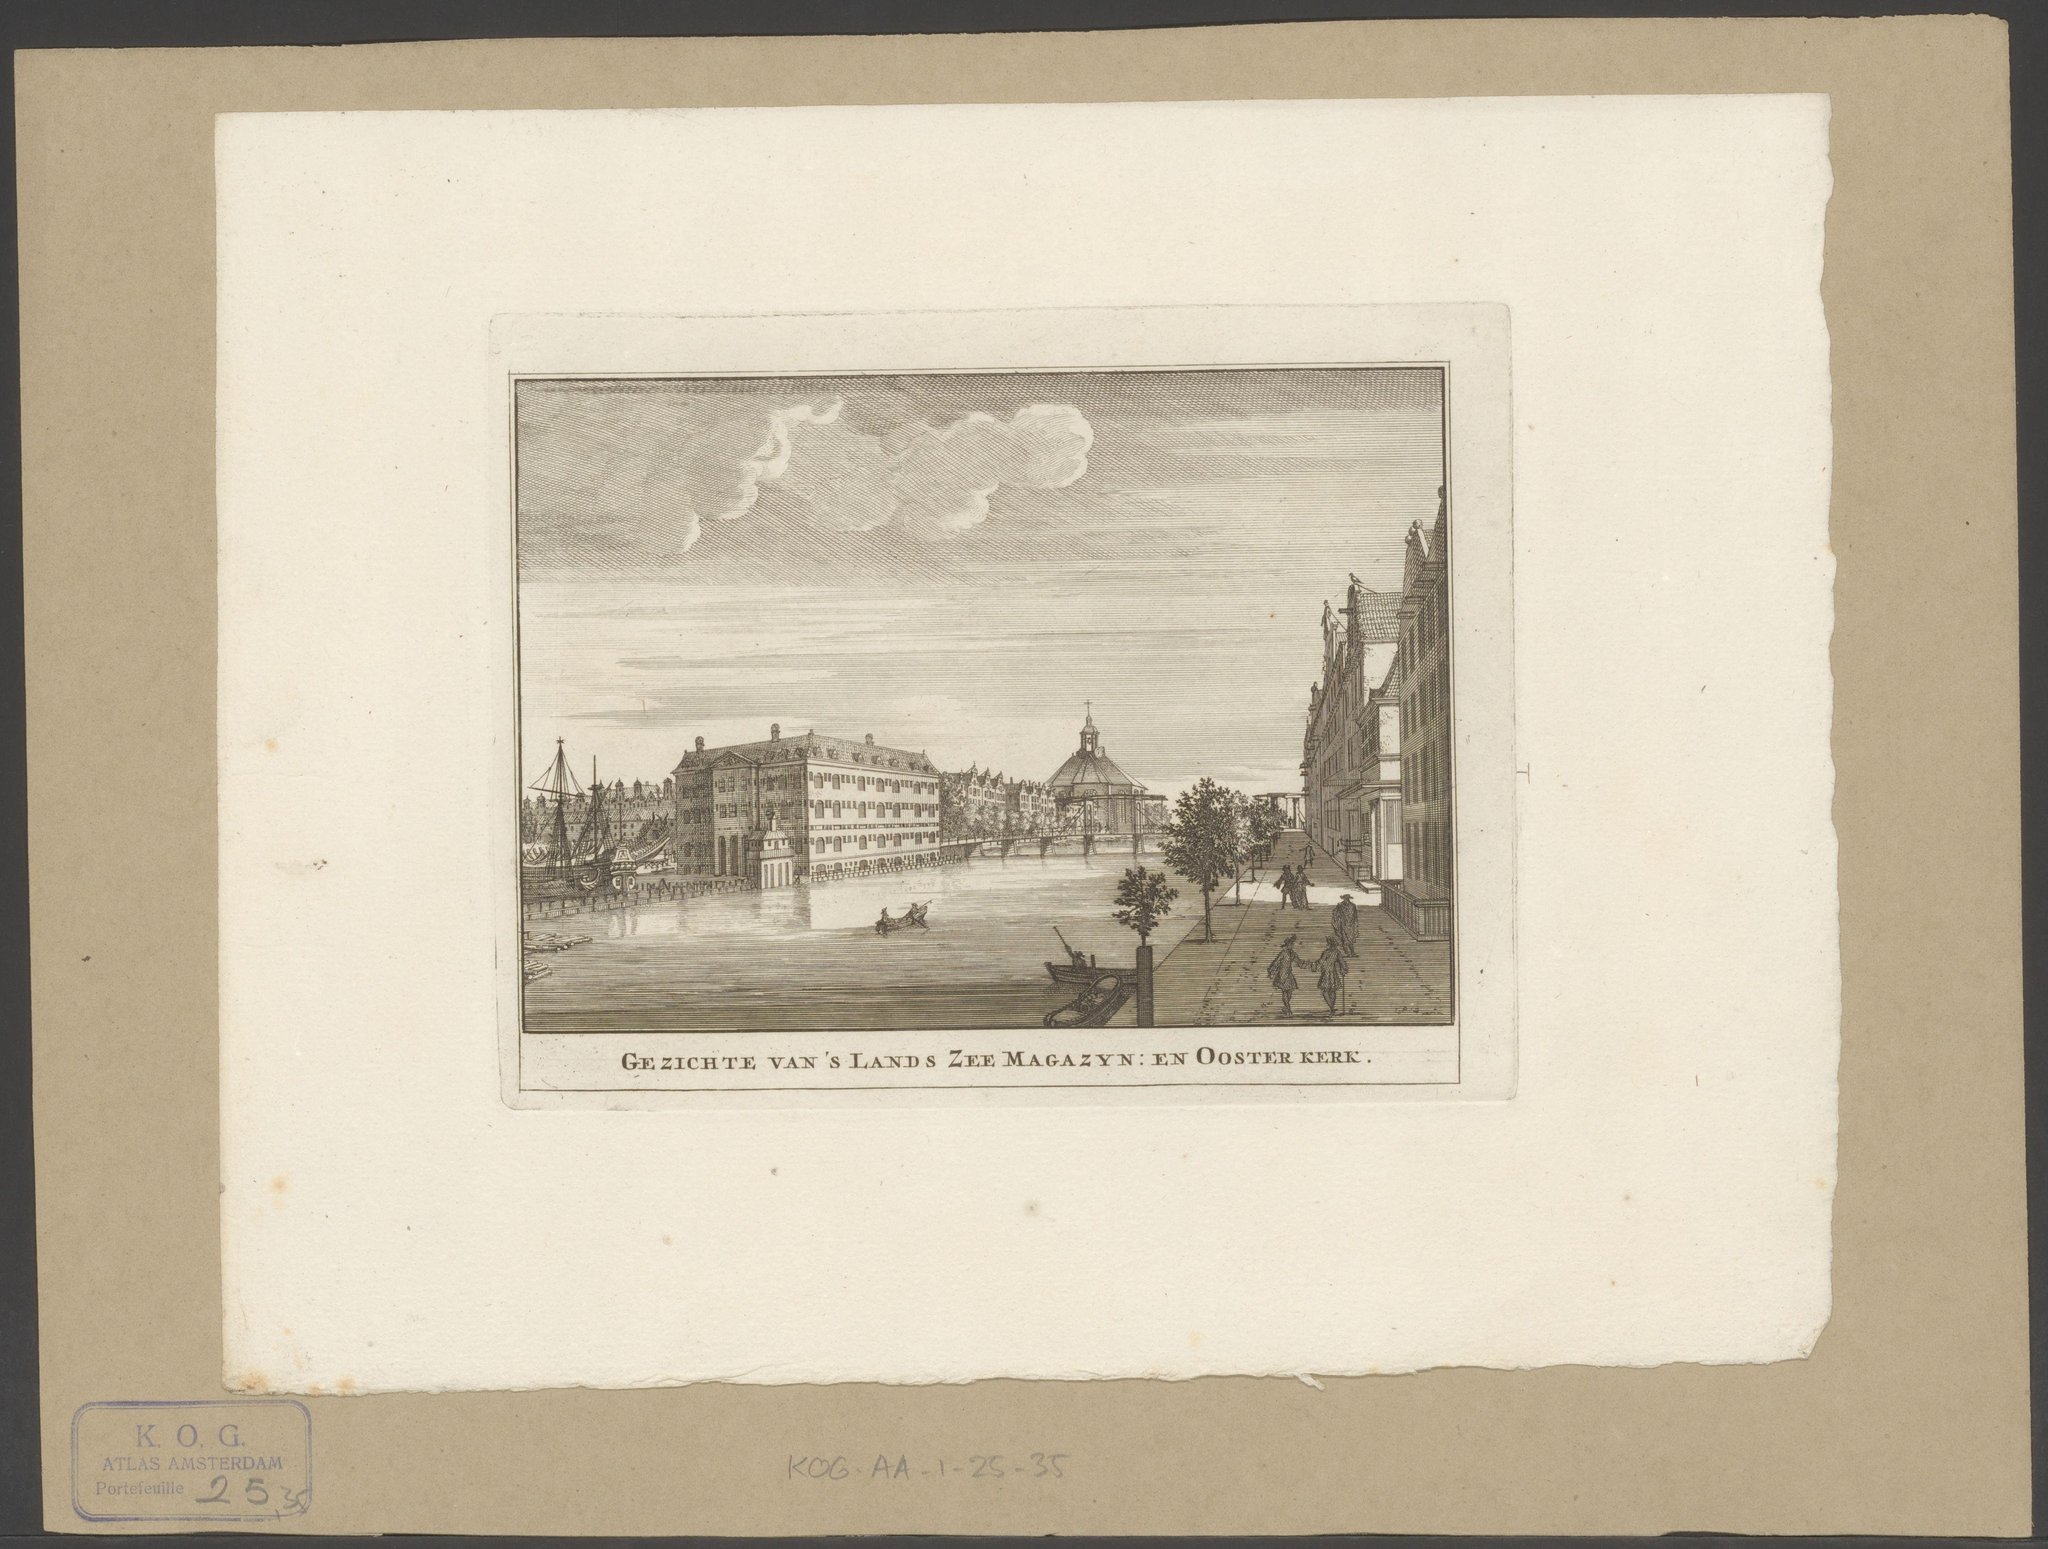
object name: print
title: Gezichte van 's Lands Zee Magazyn: en Ooster kerk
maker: Anonymous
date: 1675-1700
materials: paper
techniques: engraving, etching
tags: large-scale structure for storage, e.g.: warehouse, depot, silo, civic architecture; edifices; dwellings, ammunition store, arsenal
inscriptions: collector's mark: ‘25.35’ Lugt 1641b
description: Prent ook gebruikt in: Hoorn, Nicolaas ten. Wegwyzer door Amsterdam, Zynde eene beknopte verhandeling van desselfs eerste opkomst, vergrootingen, en teegenwoordigen staat (…). Amsterdam: Nicolaas ten Hoorn, 1713. En in: Hoorn, Nicolaas ten. Wegwyzer of korte beschryvinge der stad Amsterdam. Zynde eene Beknopte Verhandeling van derzelver eerste Opkomst, Vergrootingen en Tegenwoordigen Staat (…). Amsterdam: Pieter Meyer, 1751.